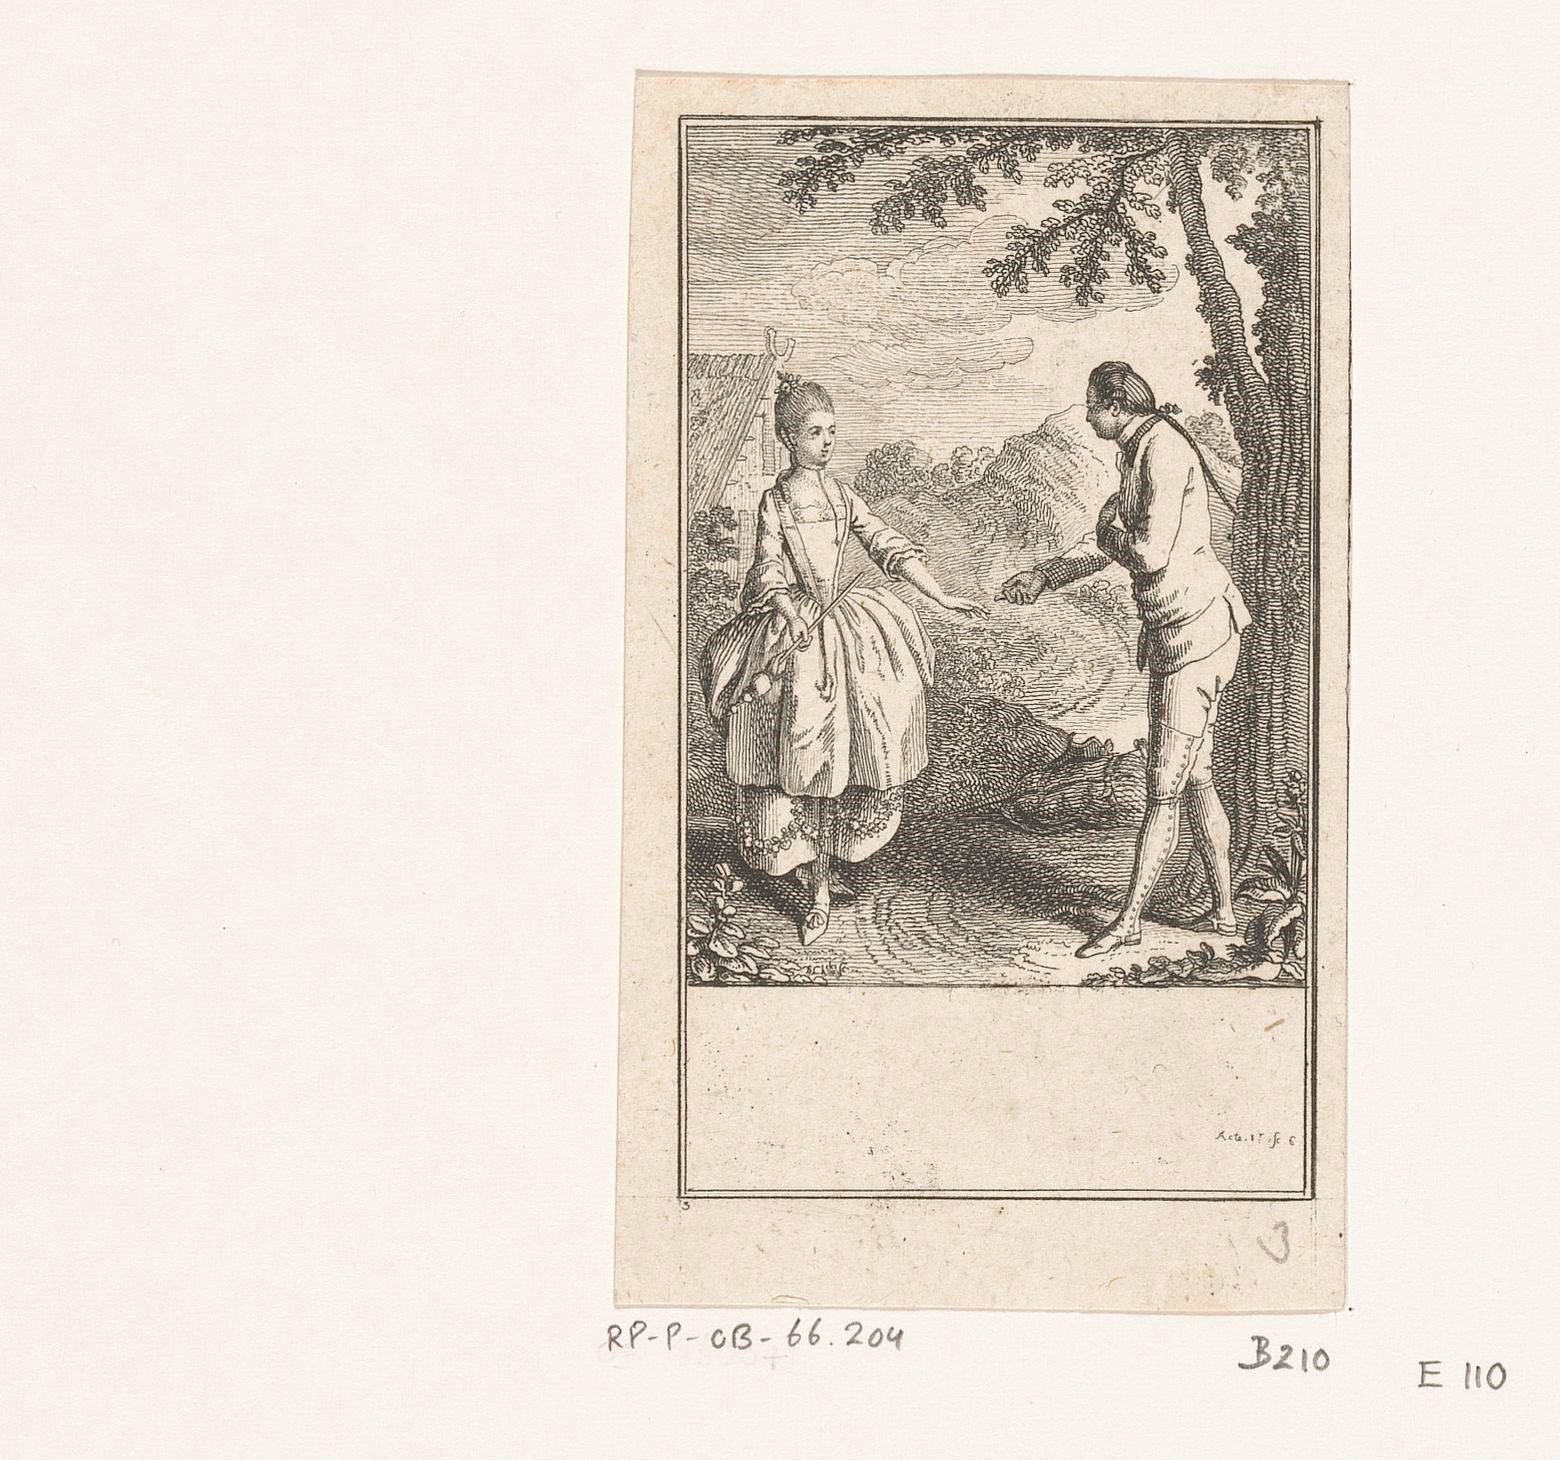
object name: print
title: Scène uit de Deserteur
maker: daniel nikolaus chodowiecki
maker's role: draughtsman, print maker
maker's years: 1726-1801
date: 1774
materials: paper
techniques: etching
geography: berlin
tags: literature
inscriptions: collector's mark: Lugt 240, collector's mark: Lugt 700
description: Derde scène uit een serie van twaalf scènes die de opéra comique 'Le déserteur' door Michel-Jean Sedaine illustreren. De scènes werden op een plaat geëtst. De tweede staat van deze serie werd ook gebruikt in: 'Berliner genealogischen Calender auf das Jahr 1775'.